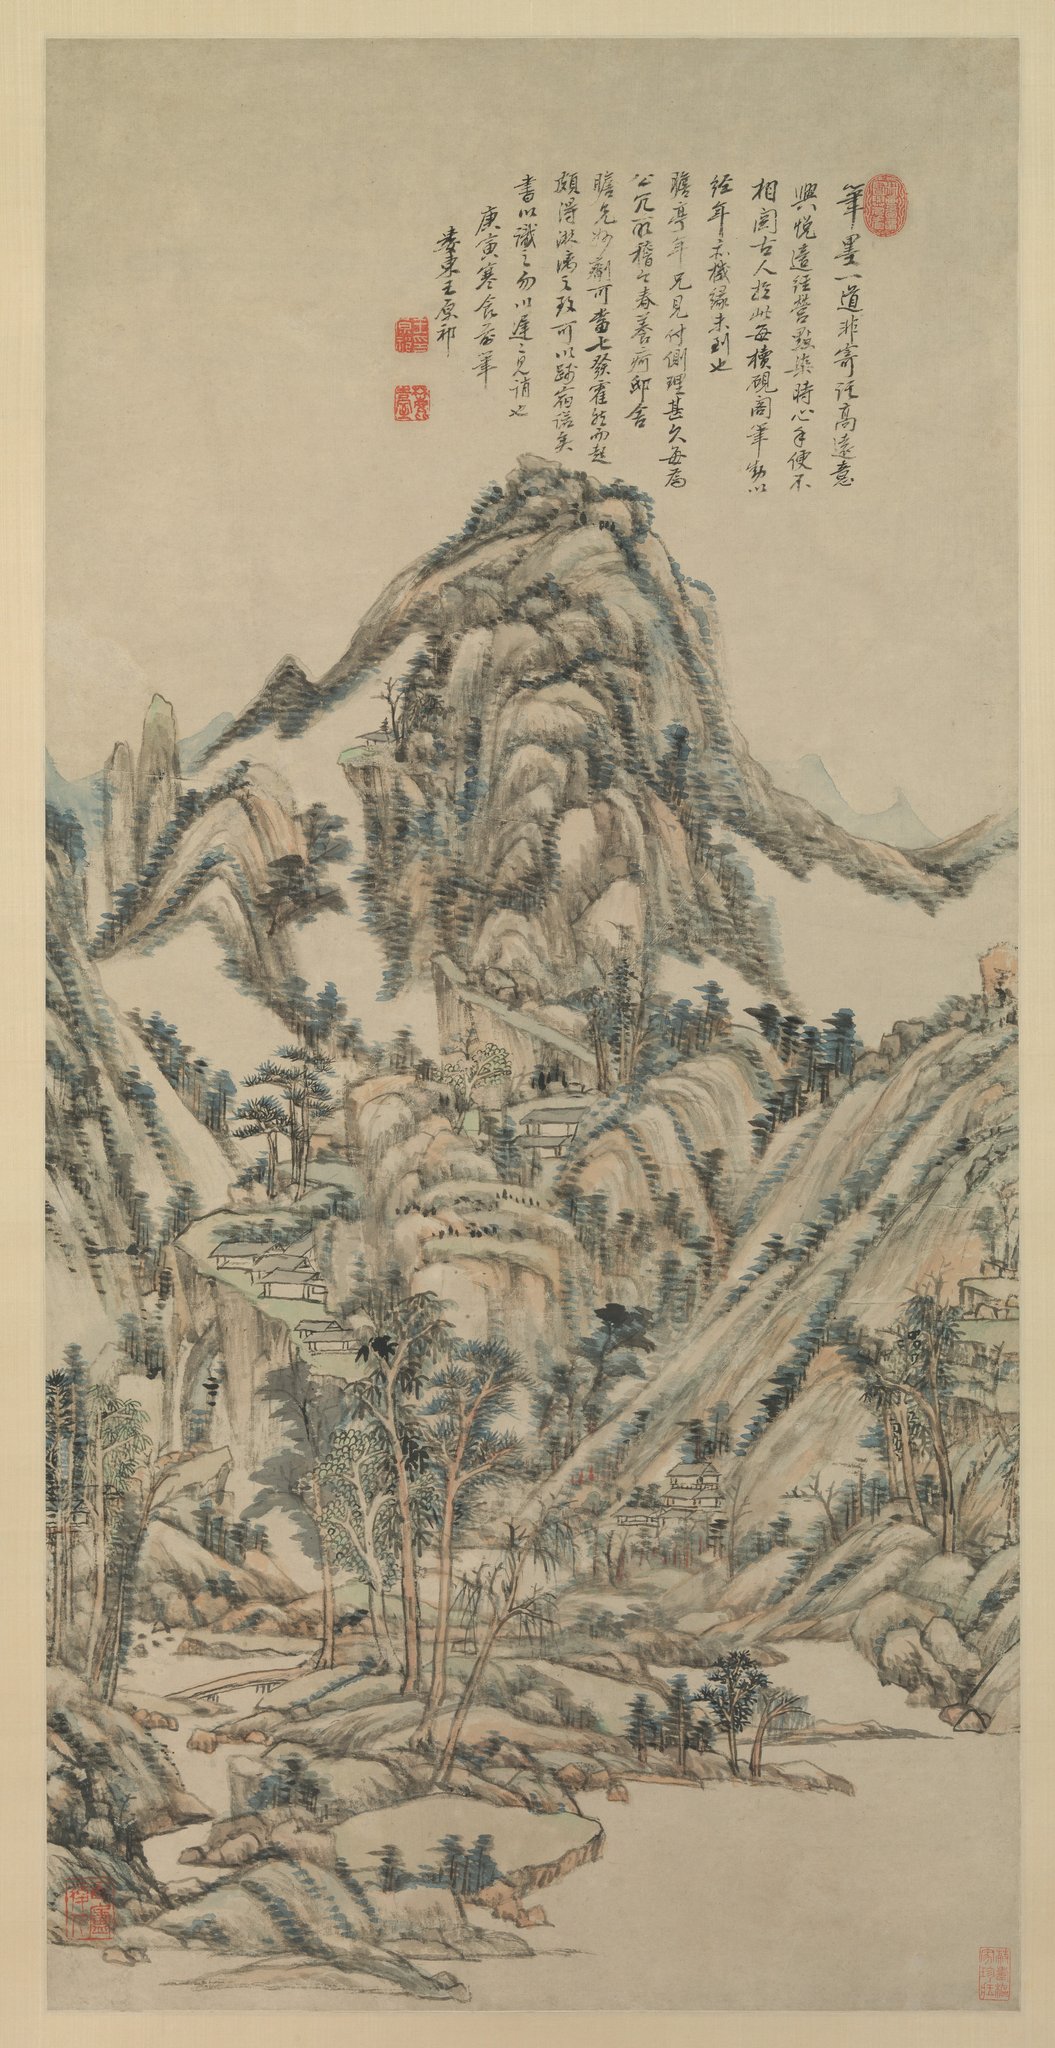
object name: hanging scroll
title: Landscape for Zhanting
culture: chinese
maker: wang yuanqi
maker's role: artist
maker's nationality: chinese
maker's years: 1642-1715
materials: ink, paper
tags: mountains,landscapes